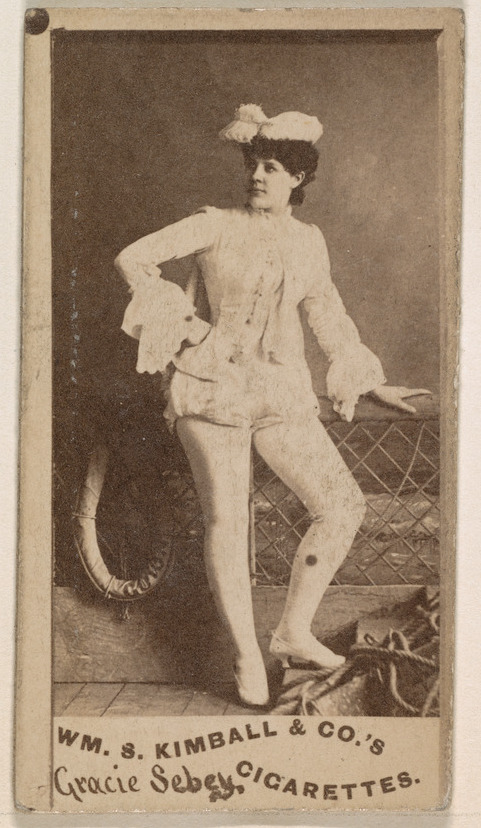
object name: photograph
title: Gracie Sebey, from the Actresses series (N203) issued by Wm. S. Kimball & Co.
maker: william s. kimball & company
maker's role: publisher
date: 1889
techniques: color lithograph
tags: portraits,women,actresses